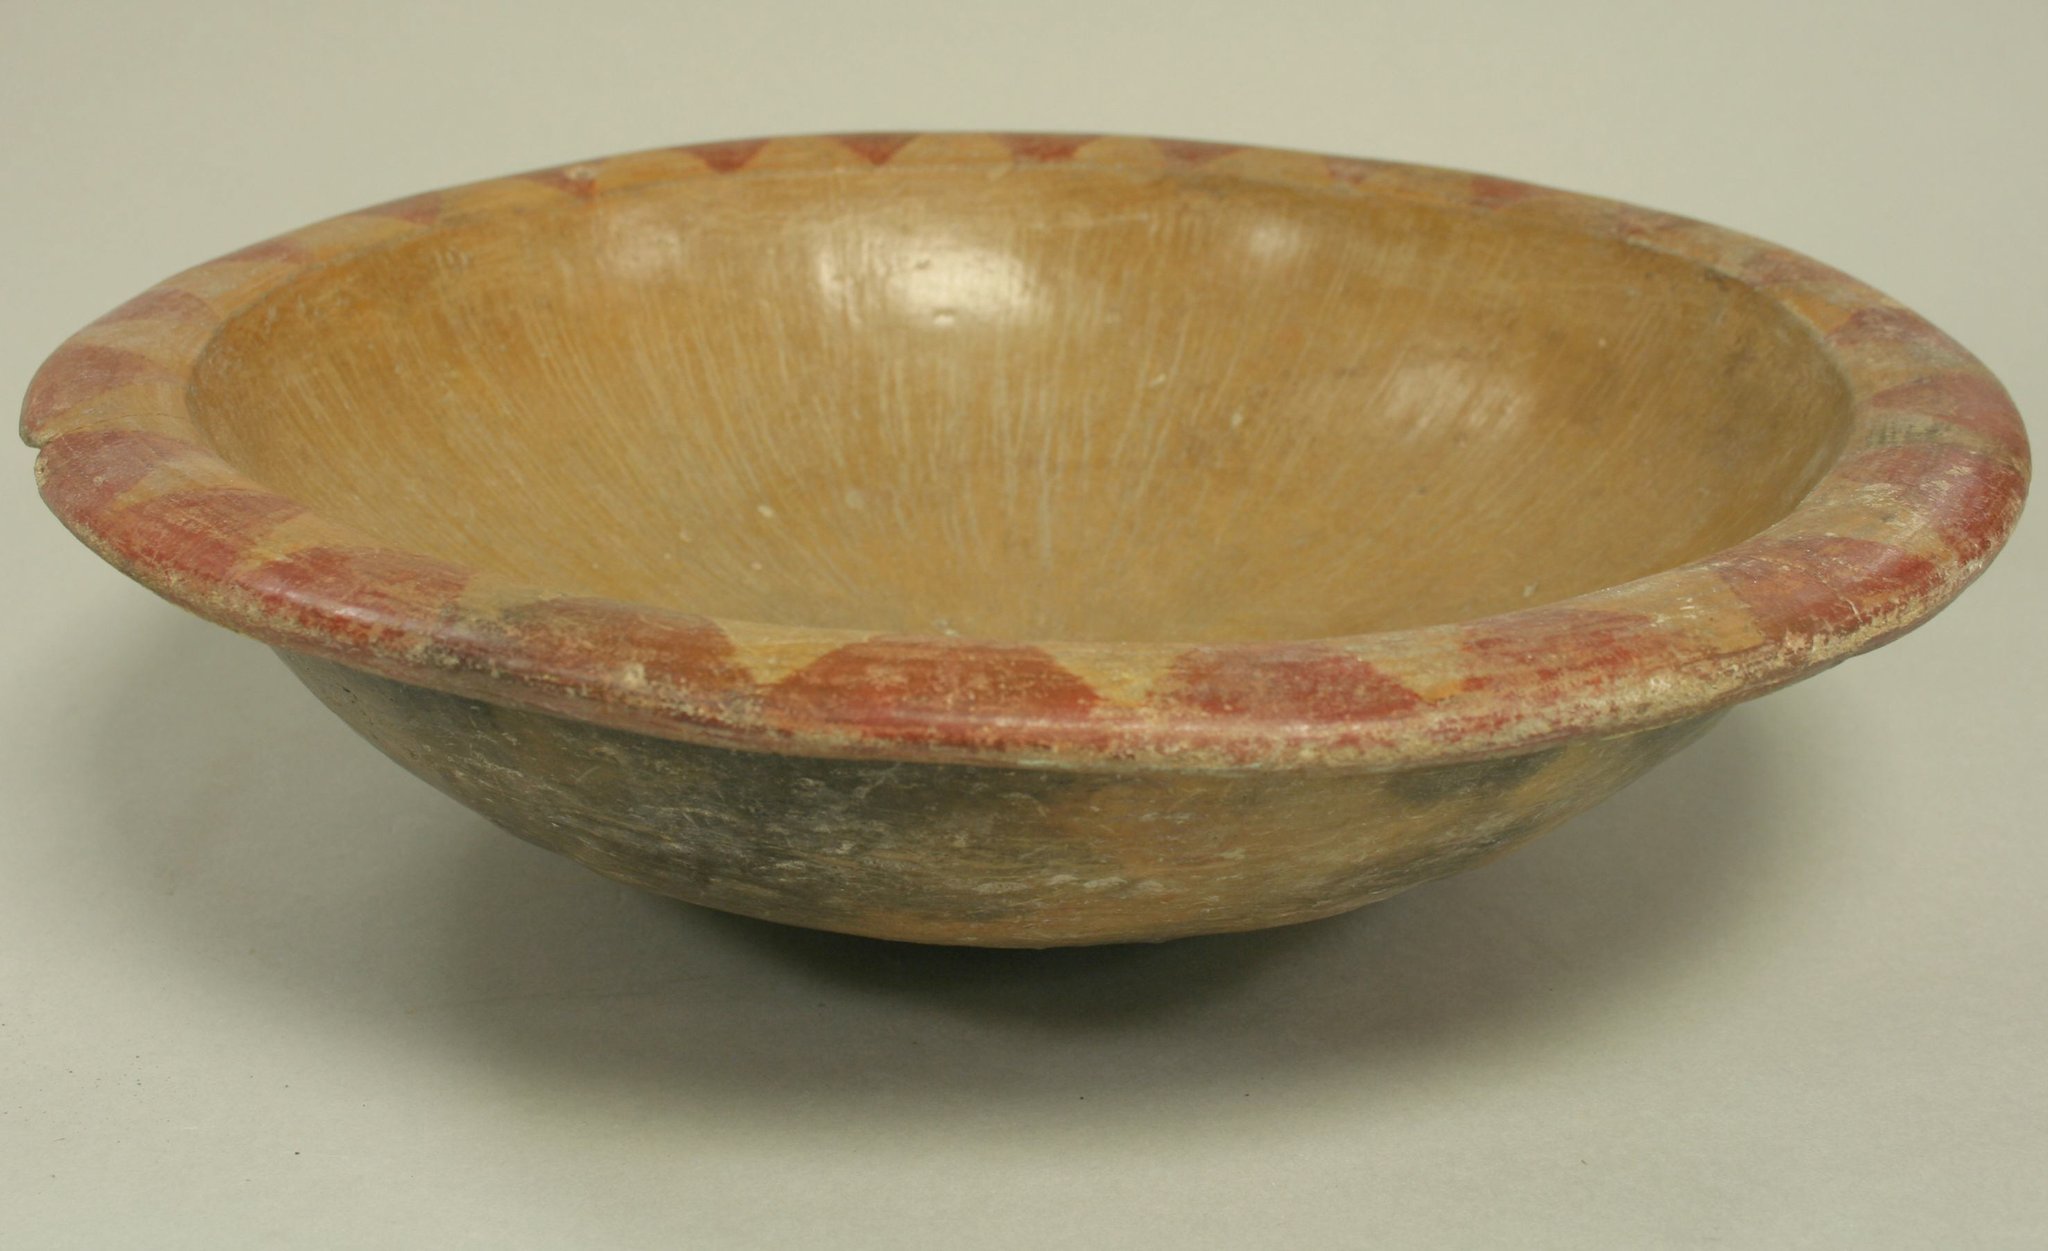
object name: bowl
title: Painted Bowl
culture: machalilla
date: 500 BCE-600 CE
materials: ceramic, pigment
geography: ecuador